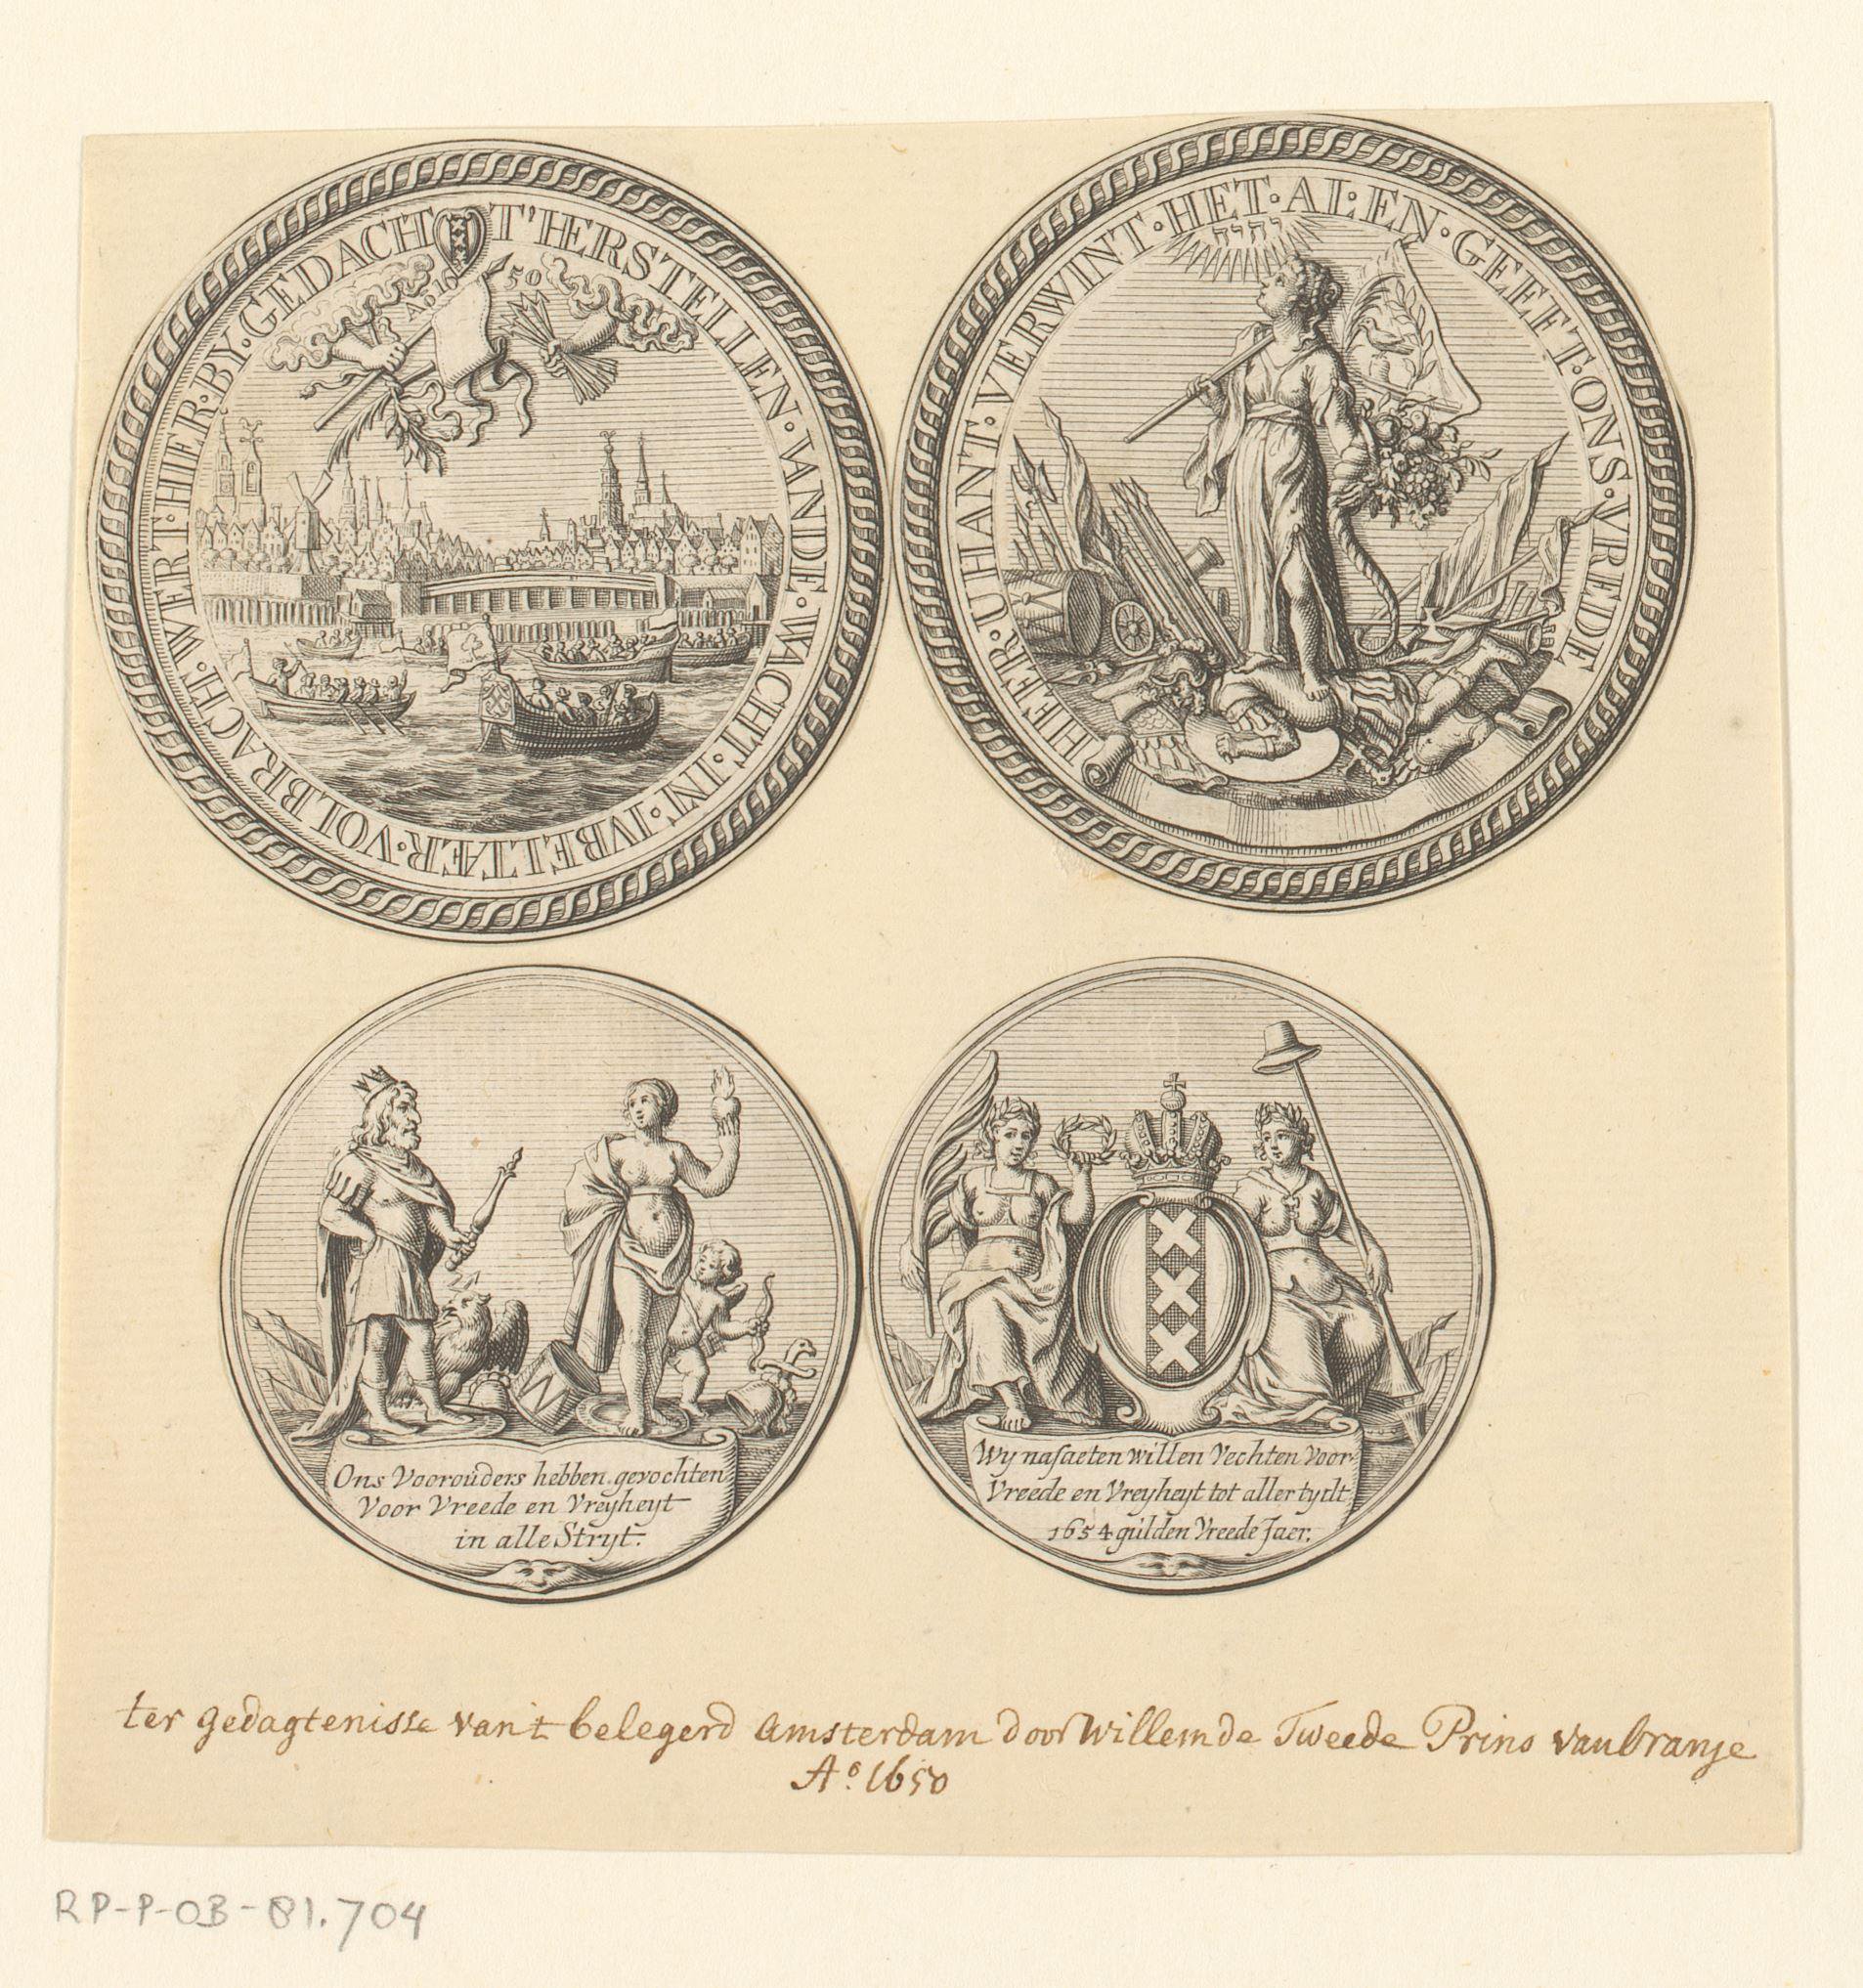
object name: historical object representation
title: Twee penningen op het beleg van Amsterdam door Willem II, 1650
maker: Anonymous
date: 1724-1726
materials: paper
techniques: etching, writing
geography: northern netherlands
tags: william ii (prince of orange), medal (considered as a piece of sculpture, regardless of its specific function), amsterdam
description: Blad met twee penningen over de gebeurtenissen te Amsterdam in het jaar 1650. Van boven naar onder. Penning 1: voorzijde: boten met soldaten op de Amstel, uit de wolken steken handen met pijlenbundel, vaandel en palmtak. Keerzijde: de Vrede staande met vaandel op wapens. Penning 2: voorzijde: het Amsterdamse wapen geflankeerd door Vrede en Vrijheid. Keerzijde: Jupiter en Vrede vertreden wapentuig. Uitgeknipte illustraties zonder tekst op achterzijde opgeplakt op een blad papier met annotatie.